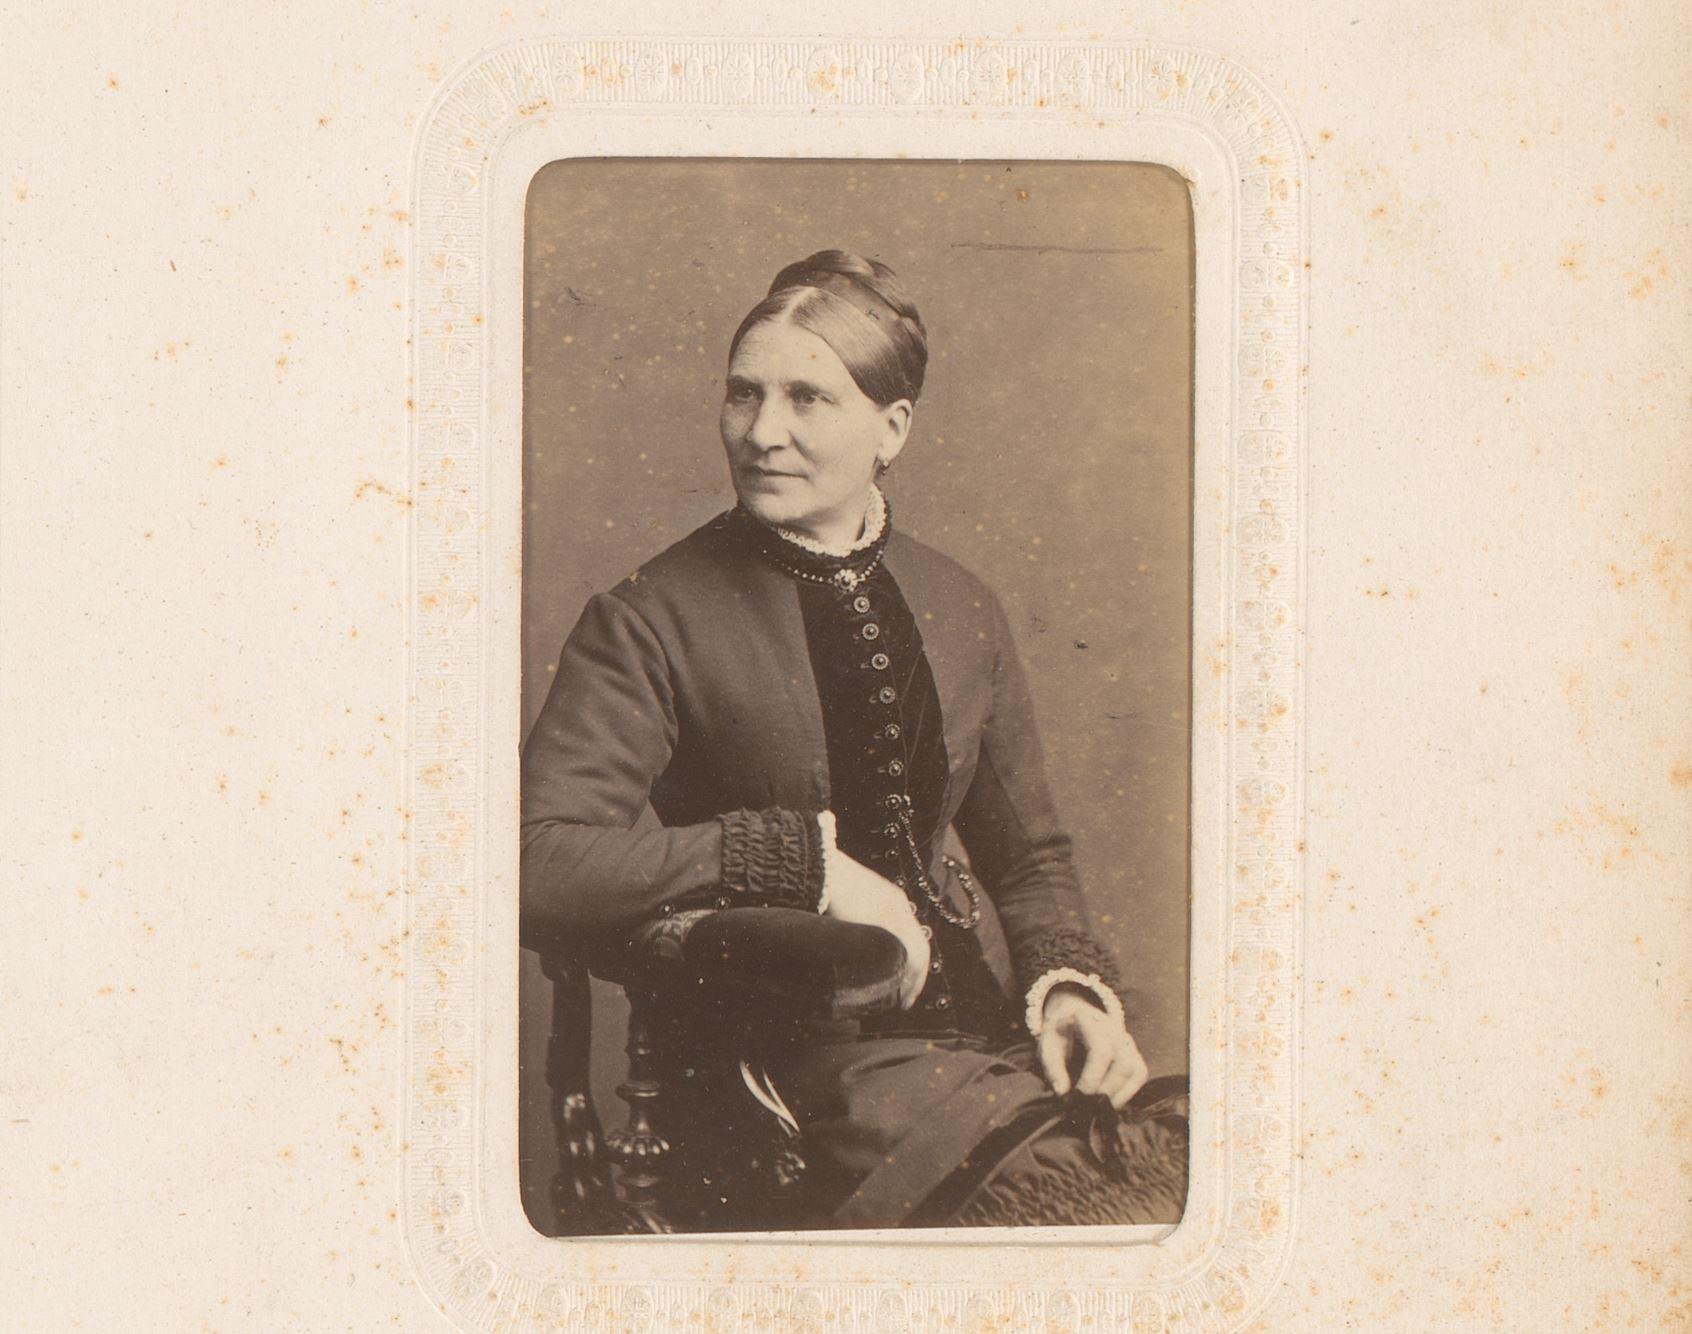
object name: photograph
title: Portret van een zittende vrouw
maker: Anonymous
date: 1860-1900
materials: cardboard, photographic support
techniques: albumen print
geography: netherlands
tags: sitting figure - aa - female human figure, historical persons - bb - woman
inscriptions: name: ‘juff Luy[...]s’